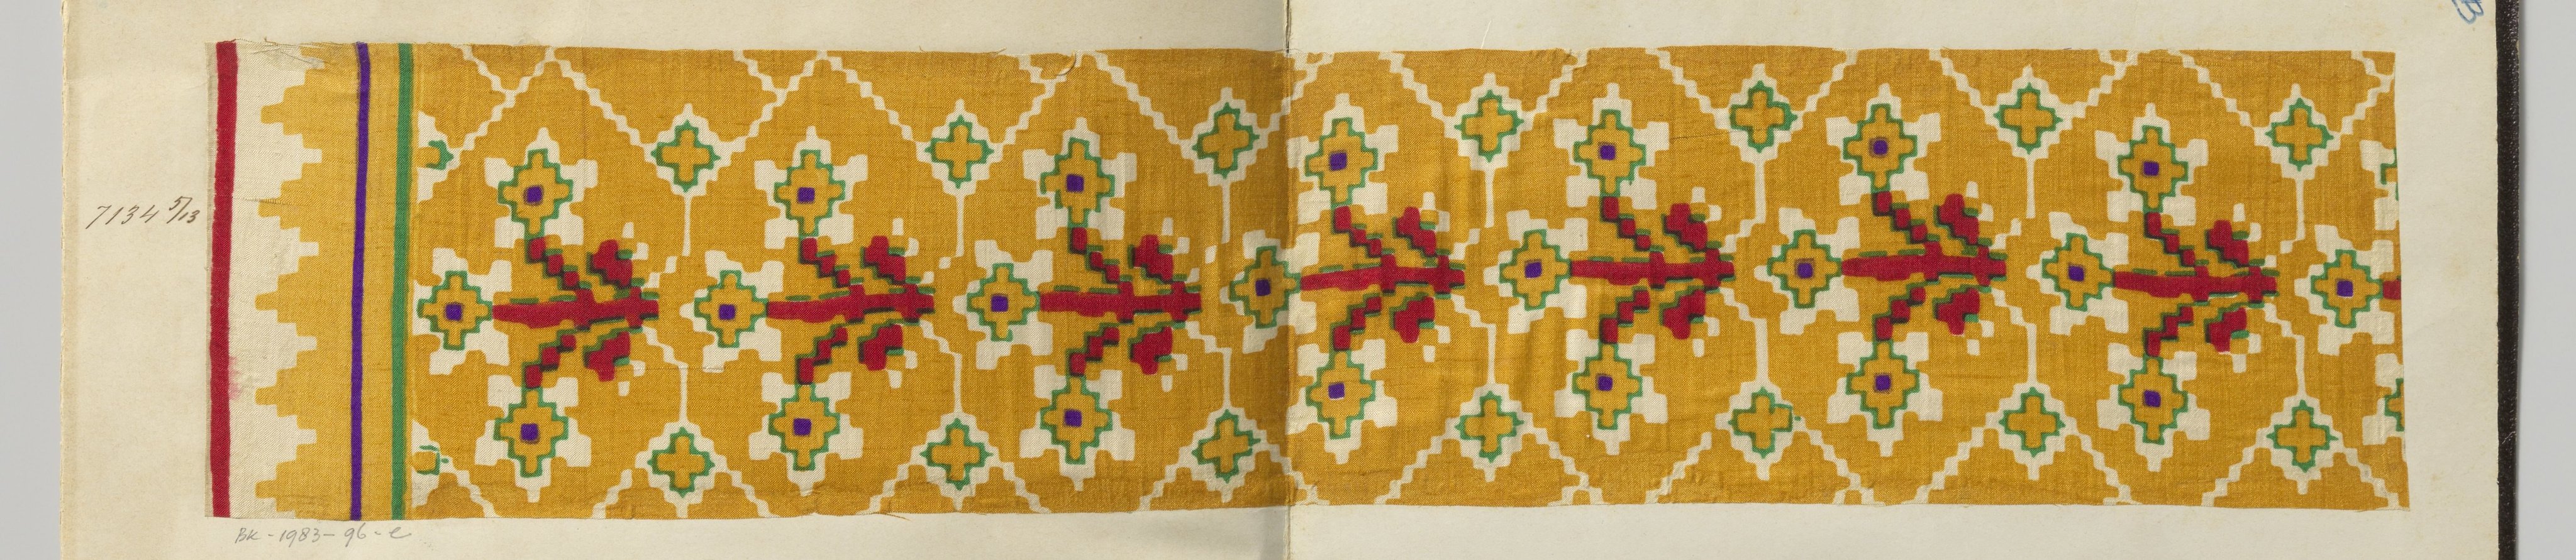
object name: sample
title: Staal zijde in album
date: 1910-1932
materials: silk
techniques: printing block, weave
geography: vienna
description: Staal bedrukte zijde, geel, groen, rood en blauw op naturel, met gestileerde bloemplant binnen paralellepipedum-vormige omlijsting (dessinnr. 7134 5/13).